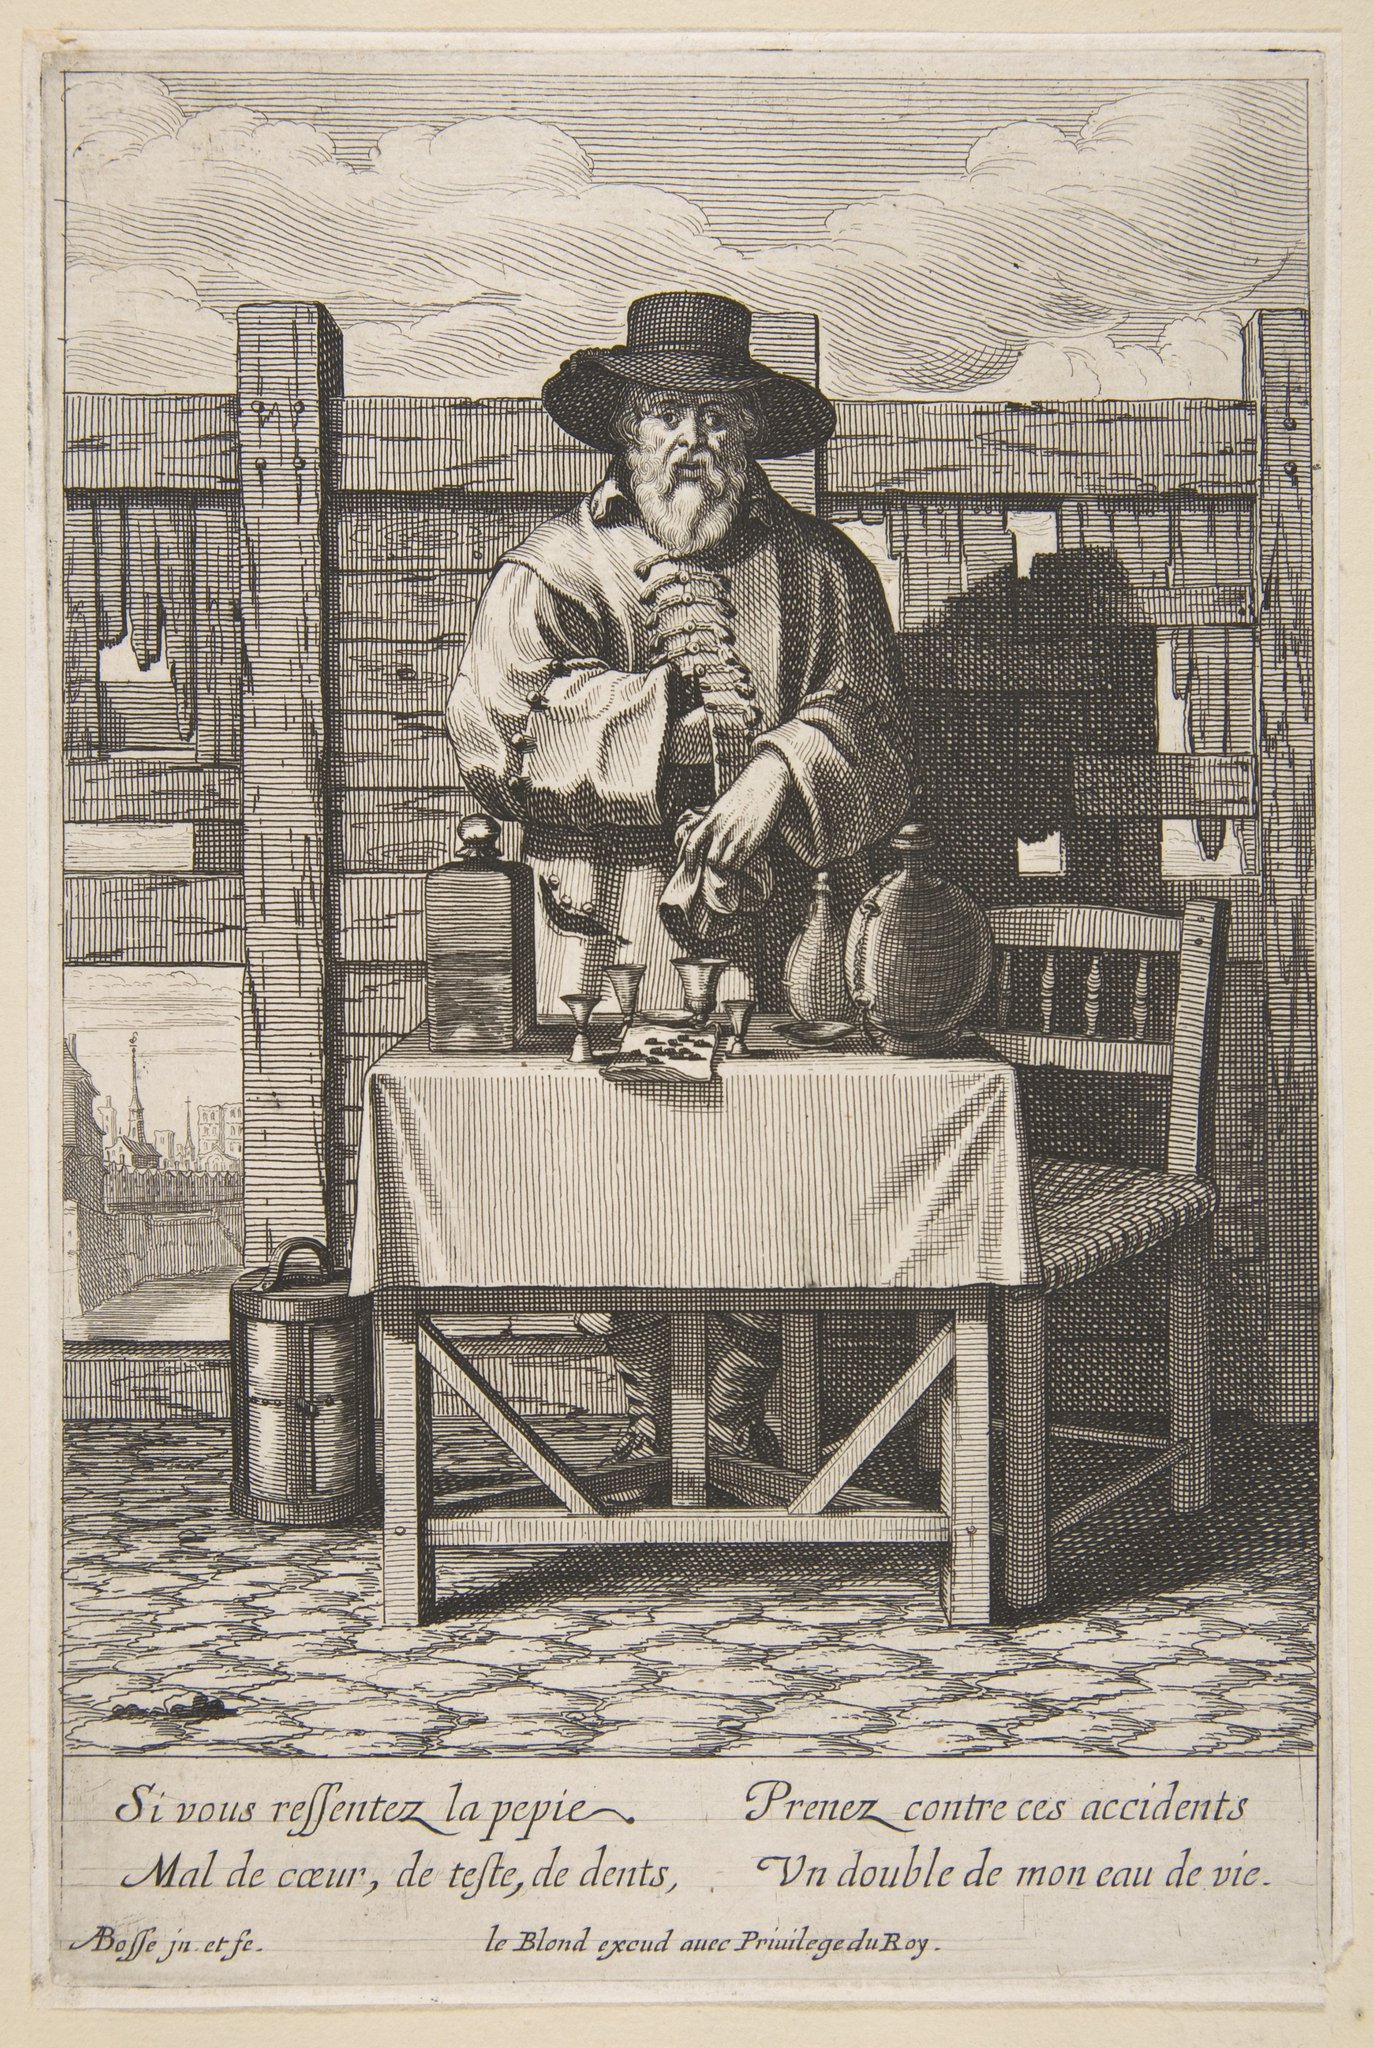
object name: print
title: Brandy or Cure Seller, plate 3 from "Cries of Paris" (Les Cris de Paris)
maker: abraham bosse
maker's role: artist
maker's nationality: french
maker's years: 1602-1676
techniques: etching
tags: wine,men,bottles,chairs,tables